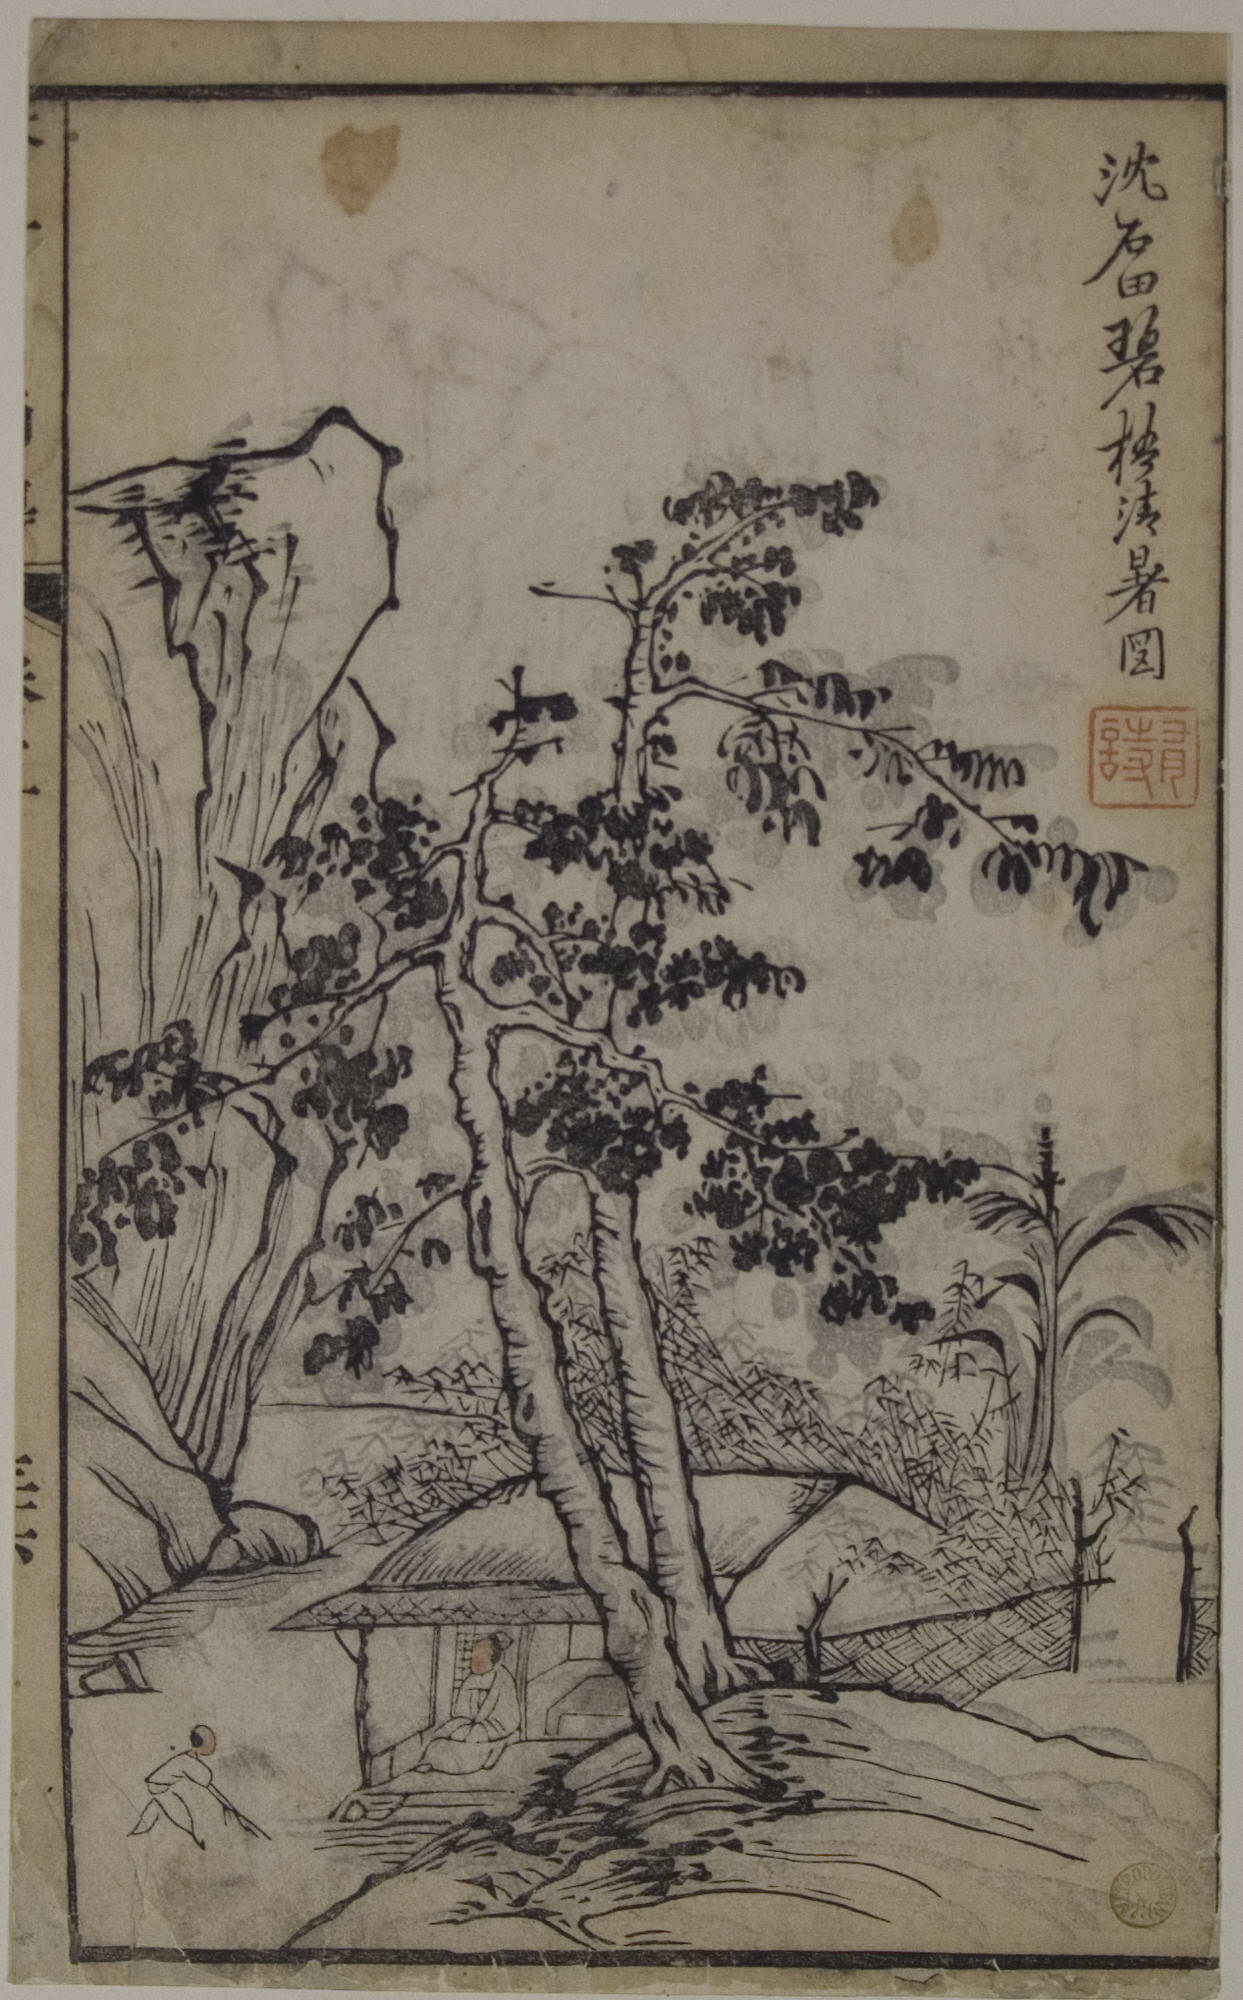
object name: print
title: A Page from the Jie Zi Yuan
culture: chinese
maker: hongren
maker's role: artist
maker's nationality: chinese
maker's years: 1610-1664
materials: ink, paper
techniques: polychrome, woodblock print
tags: landscapes,trees